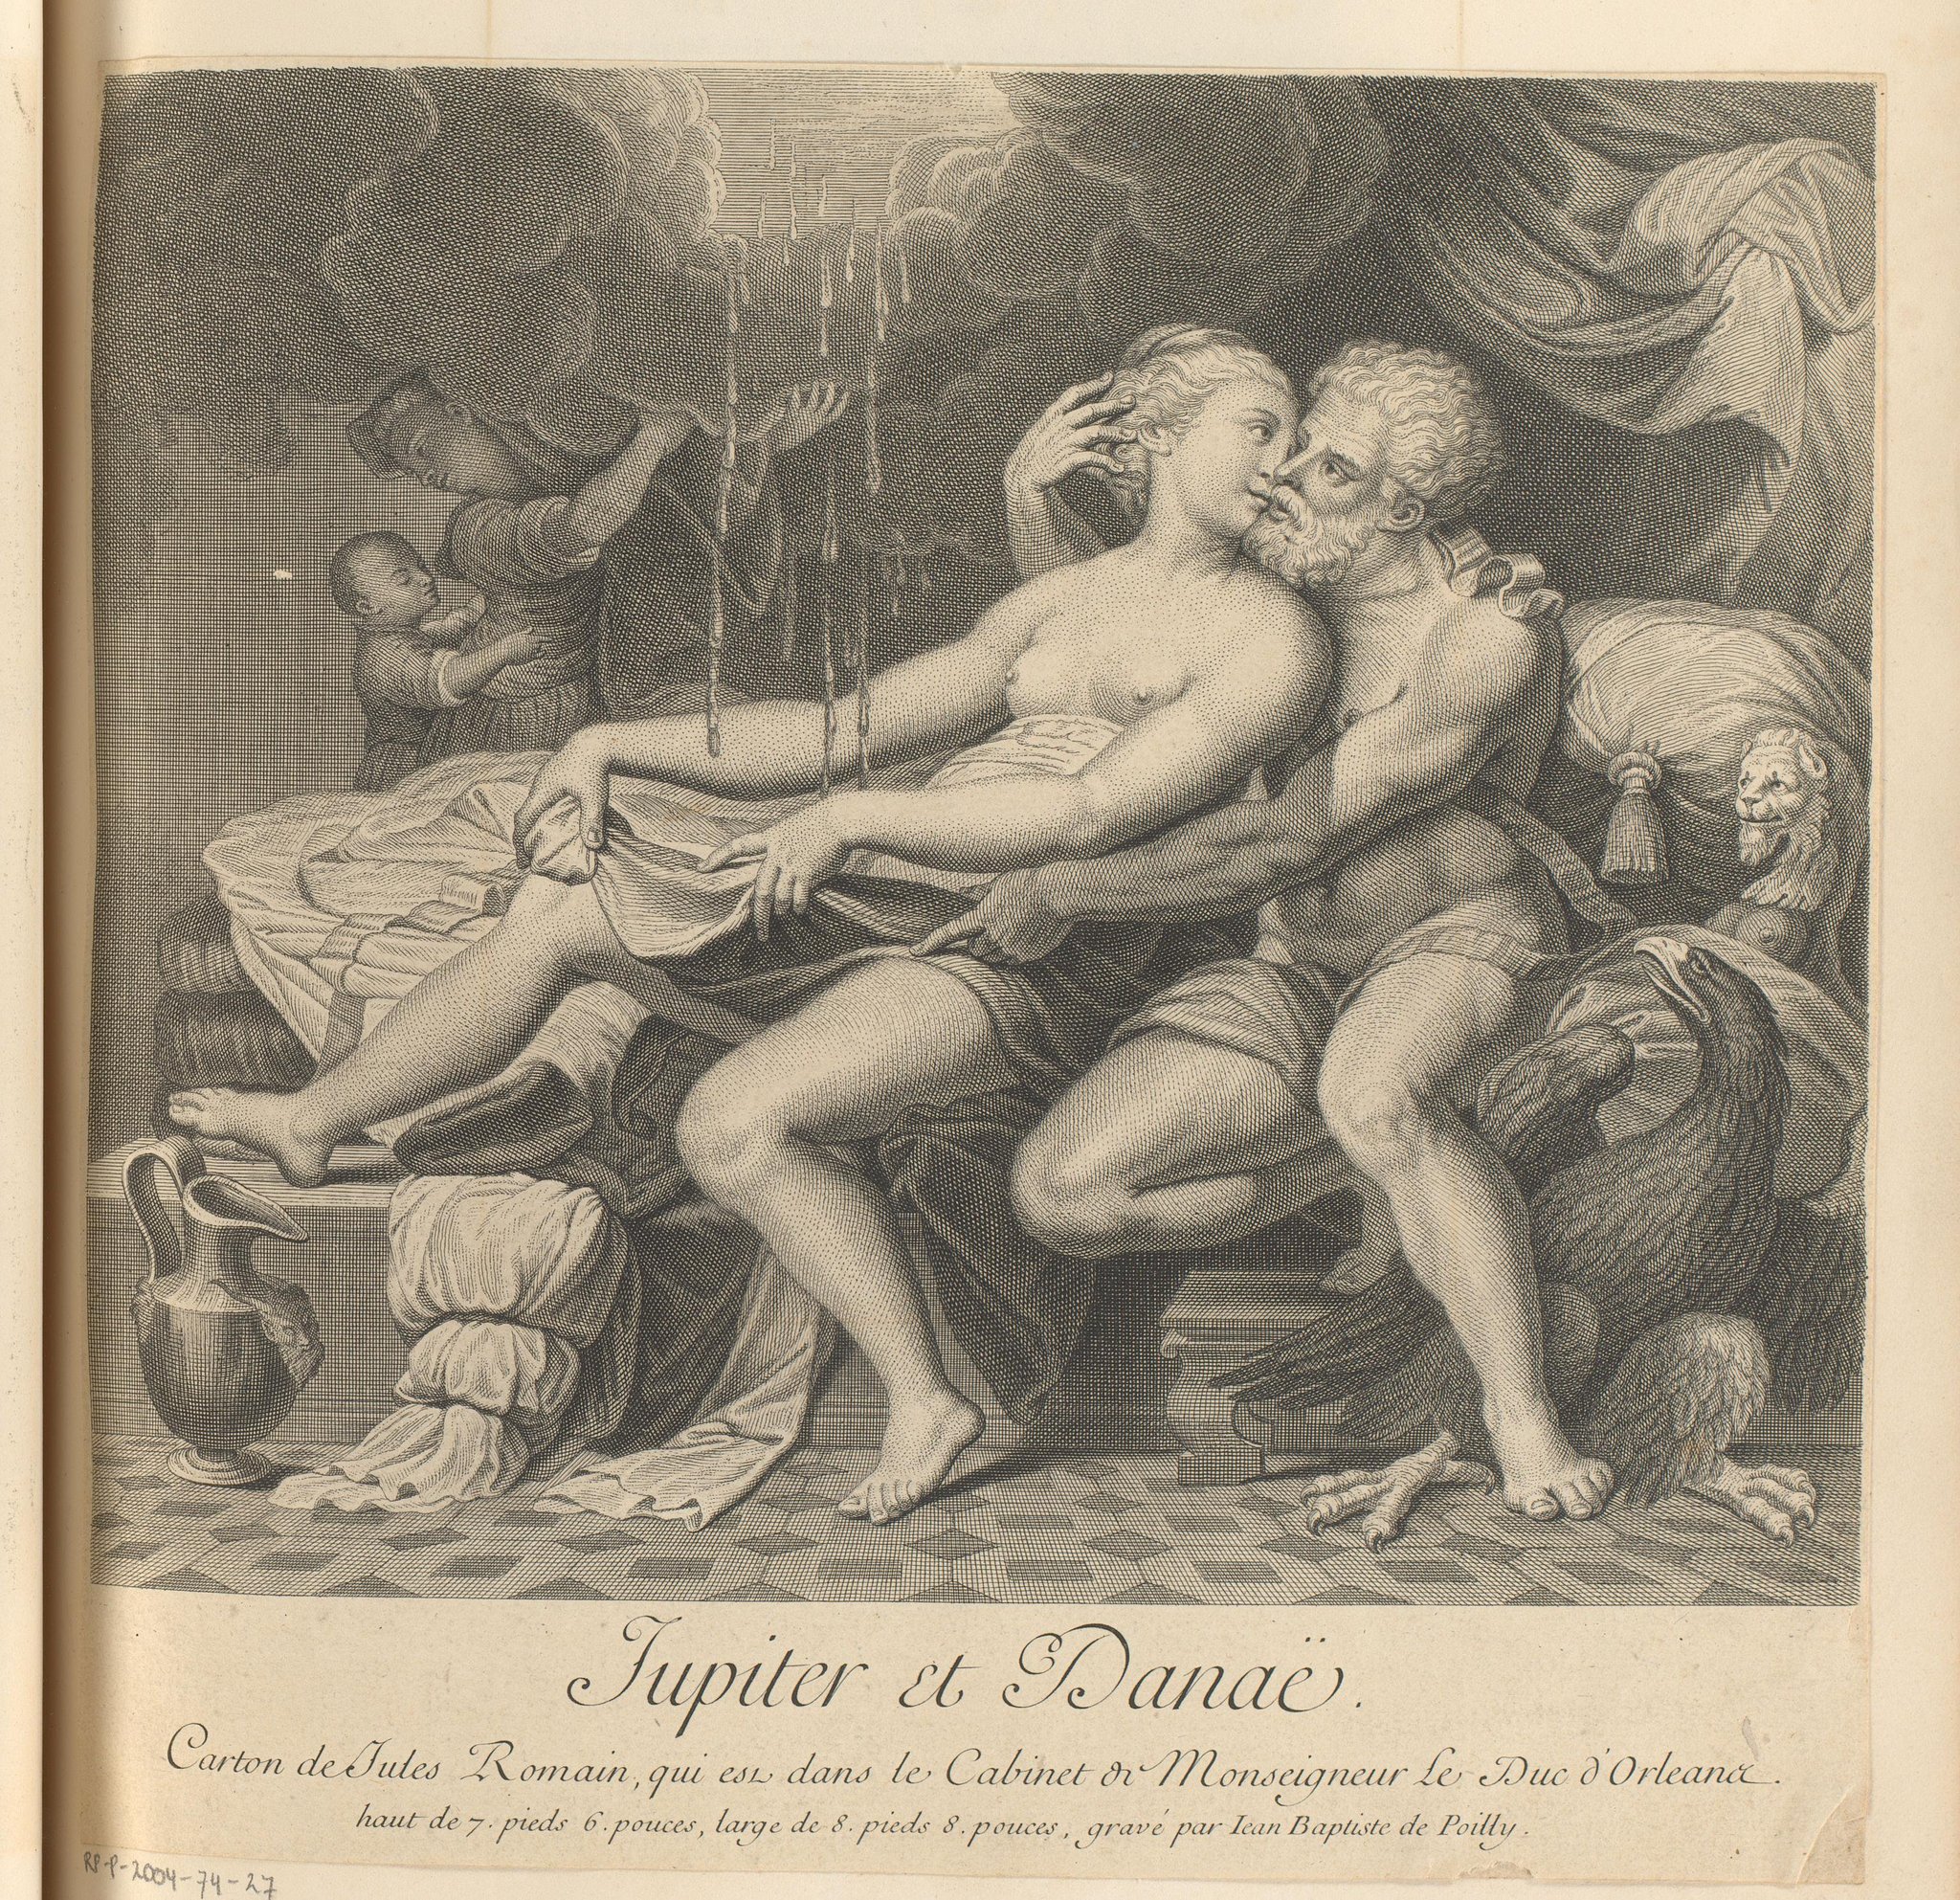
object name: print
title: Belangrijke schilderijen en tekeningen in Franse collecties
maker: jean baptiste de poilly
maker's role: print maker, publisher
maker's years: 1669-1728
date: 1729-1740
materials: paper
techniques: engraving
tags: jupiter wooing danae; she is usually lying in bed receiving a shower of gold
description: Serie ook bekend als 'Recueil Crozat'. Een eerdere staat van deze prent is gebruikt in deel 1 en had nummer 62 van de 140 prenten in de eerst uitgegeven serie tussen 1720 en 1740. De prent is ook gebruikt in de uitgave door Basan getiteld 'Recueil d'après la gallerie du palais royal' uitgegeven tussen 1762 en 1771 en heeft hierin nummer 15. Deze prent heeft echter geen nummer. De samensteller heeft deze prent in het album geplakt als illustratie bij: Pilkington, Matthew en Johann Heinrich Füssli. A dictionary of painters, from the revival of the art to the present period. 4 dln. Londen: John Crowder, 1805, dl. 3, p. 402.